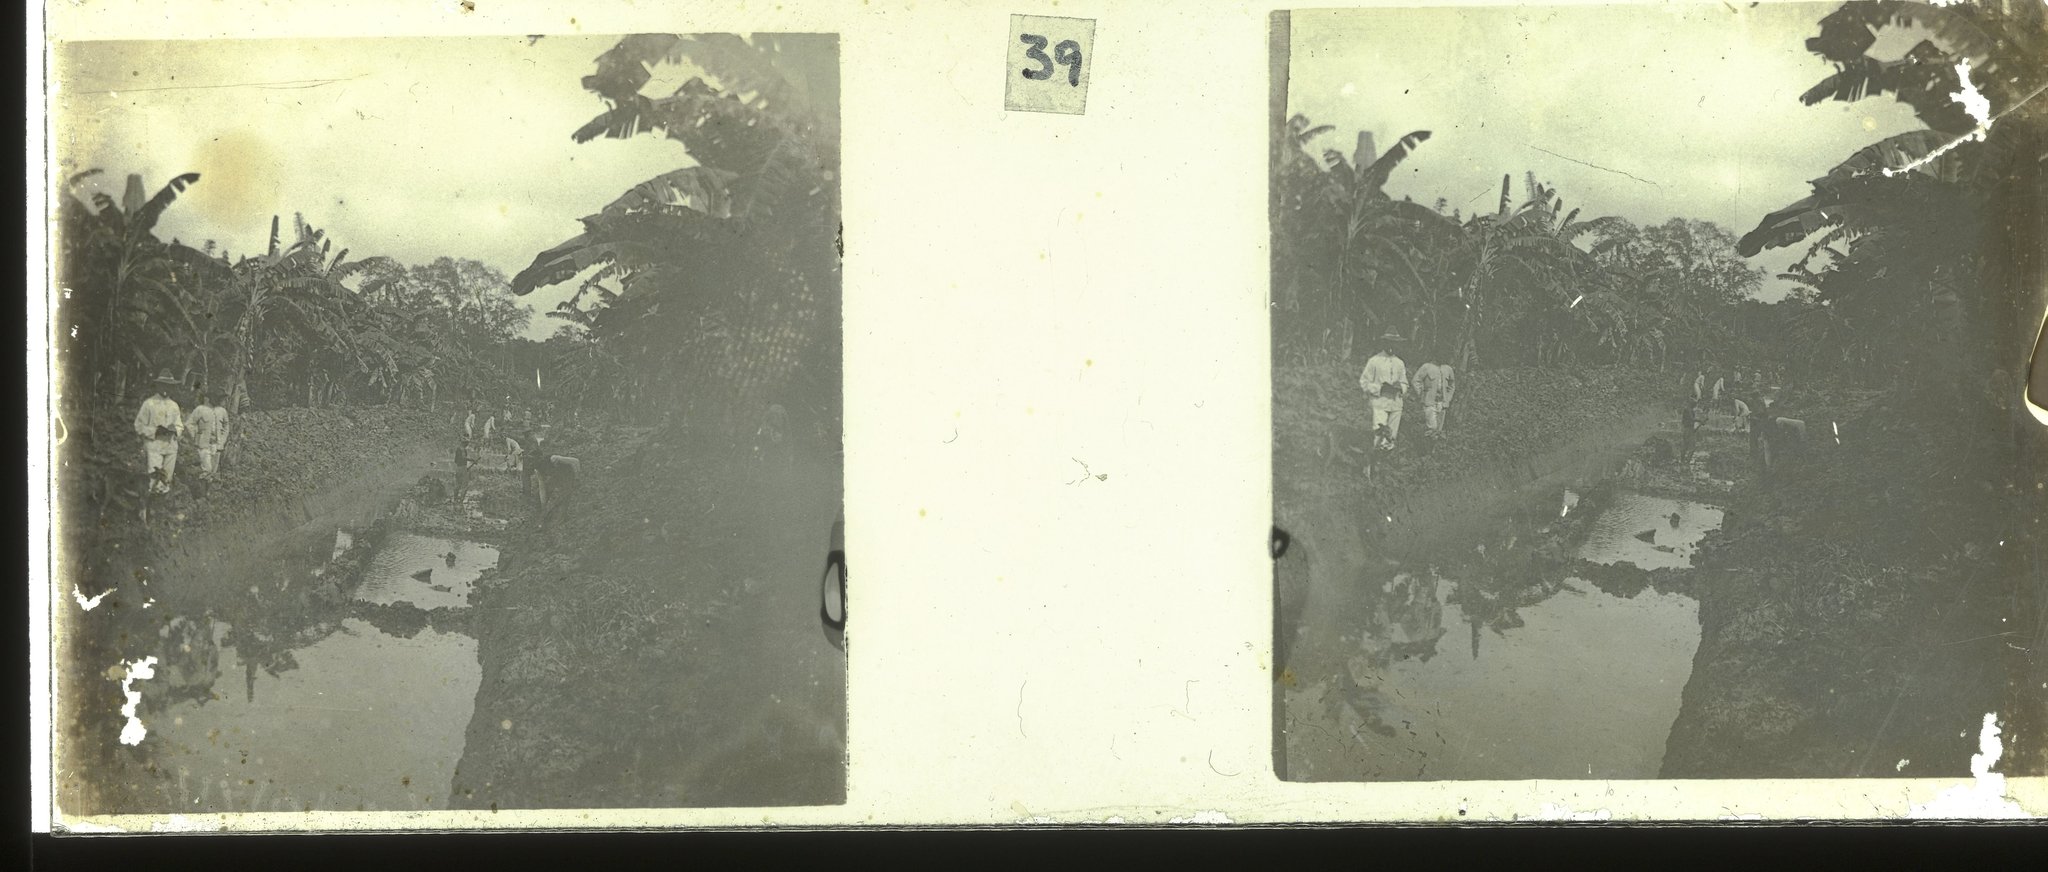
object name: stereograph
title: Opzichters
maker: theodoor brouwers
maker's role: amateurfotograaf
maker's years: 1874-1932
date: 1913-1930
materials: glass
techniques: photography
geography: suriname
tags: amsterdam, theodoor brouwers, plantation, suriname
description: In de periode 1911-1932 woonde op plantage Accaribo in Suriname de familie Brouwers van wie de foto's afkomstig zijn. Rond 1910 vond Theodoor Brouwers werk op plantage Accaribo. In 1929 werd hij eigenaar van de plantage. Op Accaribo werden in zijn tijd bananen geproduceerd en wat koffie.